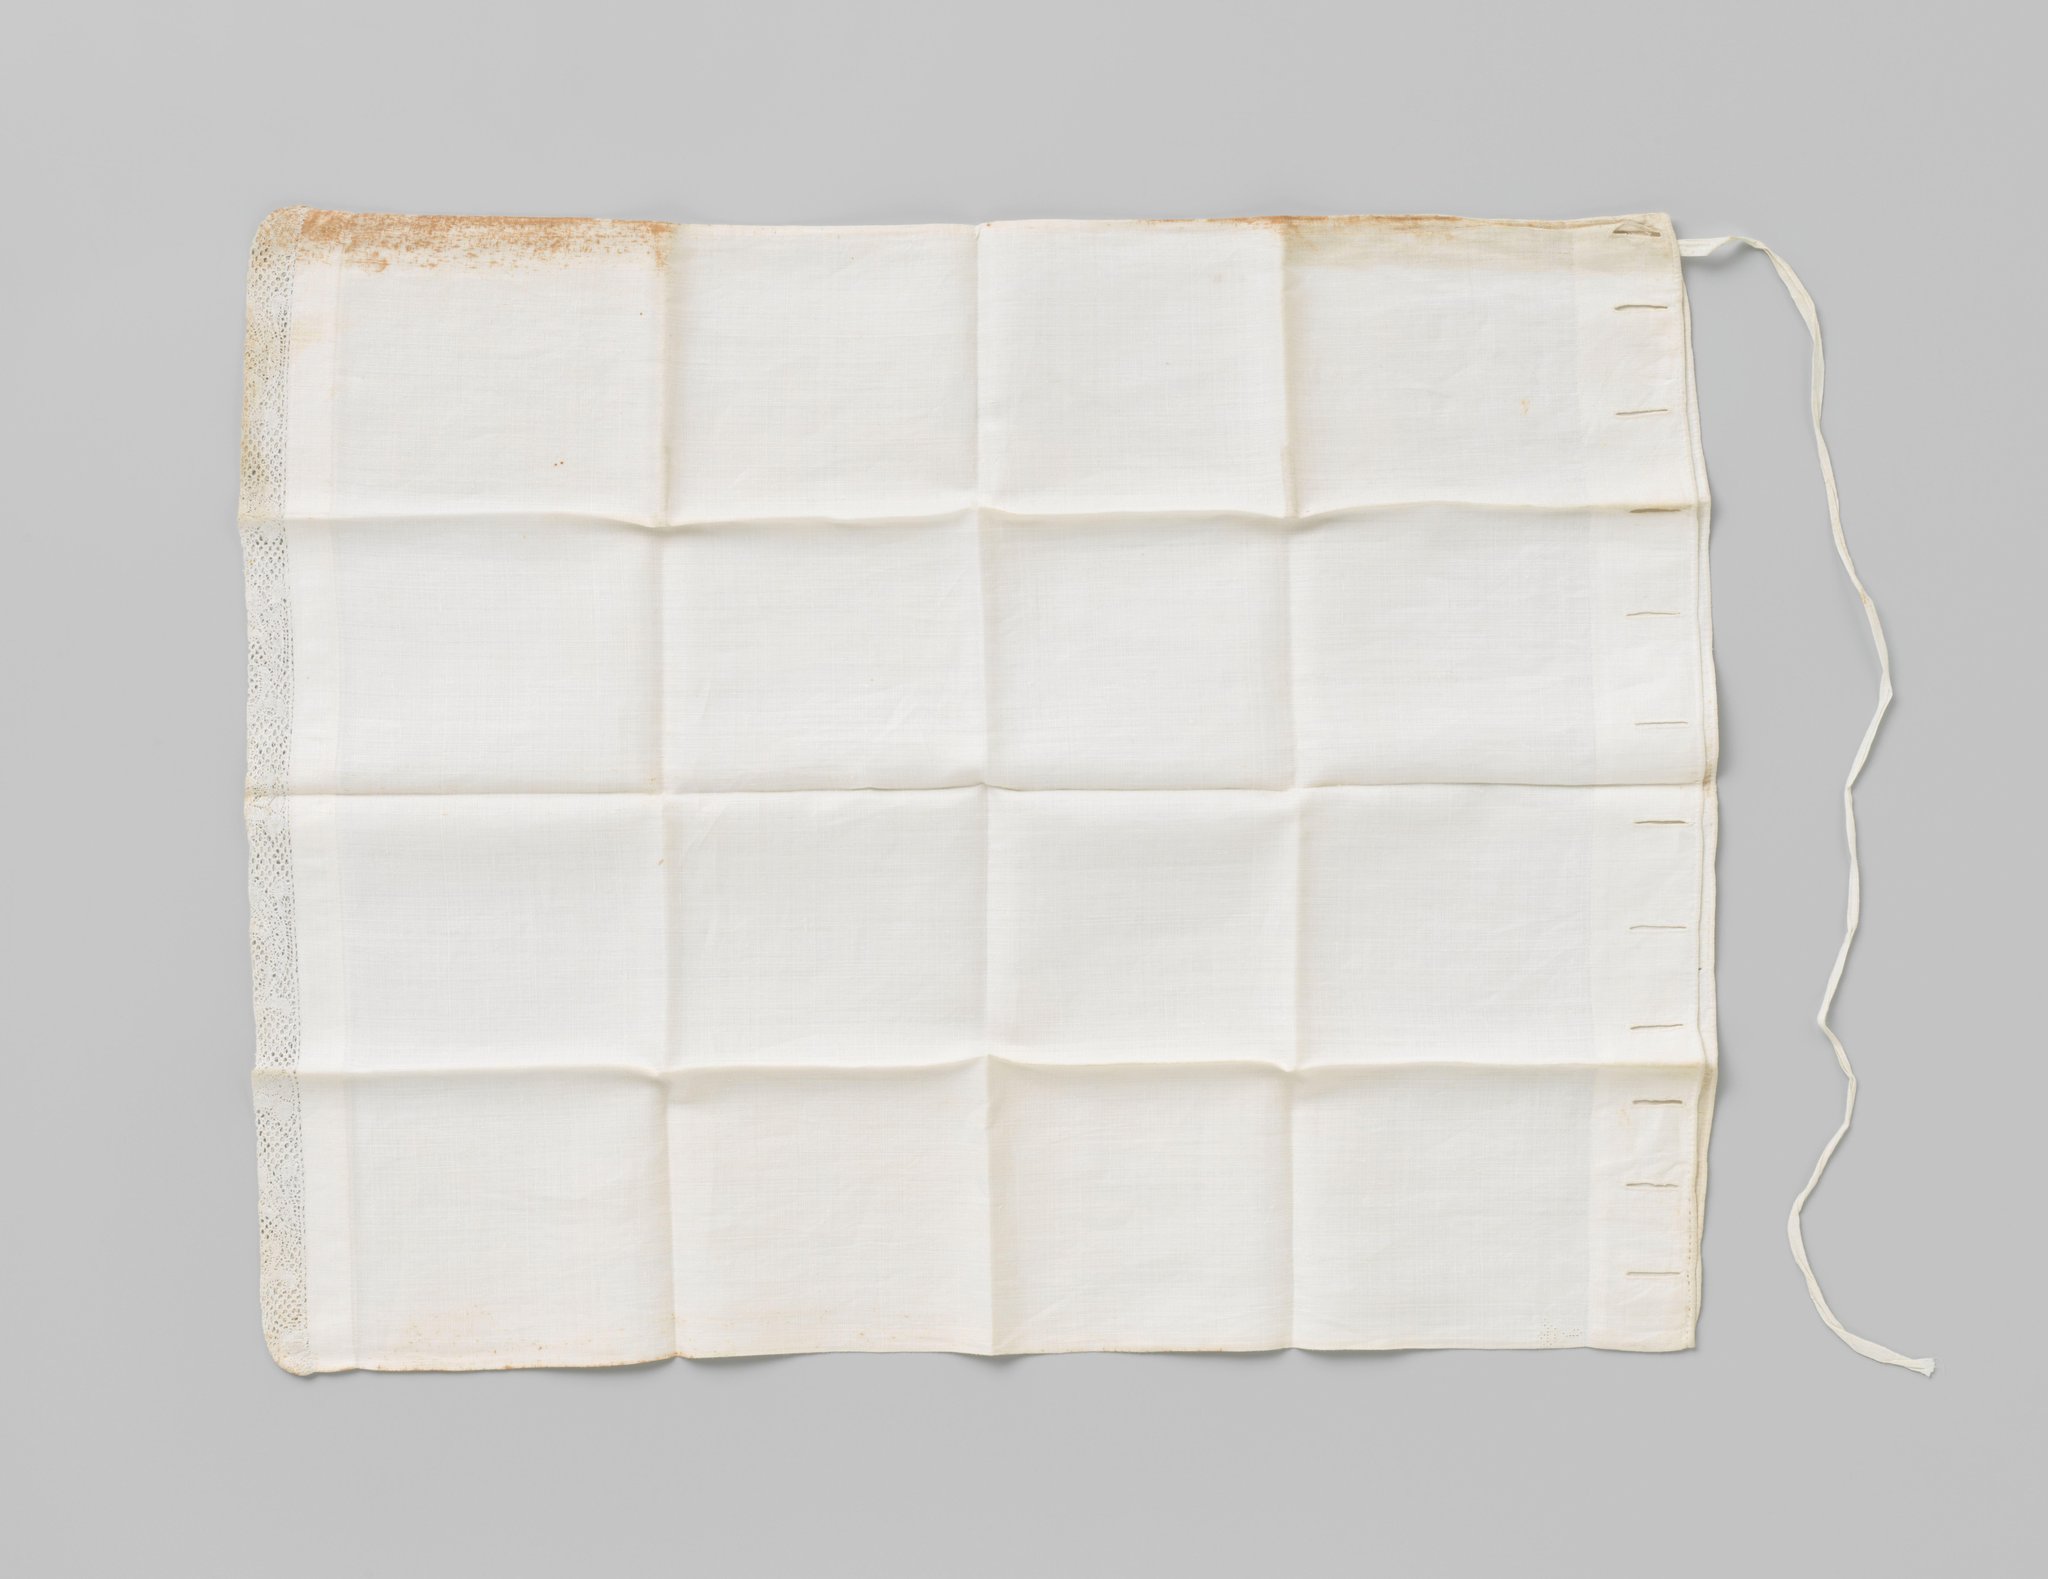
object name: lendensloop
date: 1734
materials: linen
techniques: lace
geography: northern netherlands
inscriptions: date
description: Lendensloop van linnen met entre-deux van kloskant, merk kroon B en 1734.